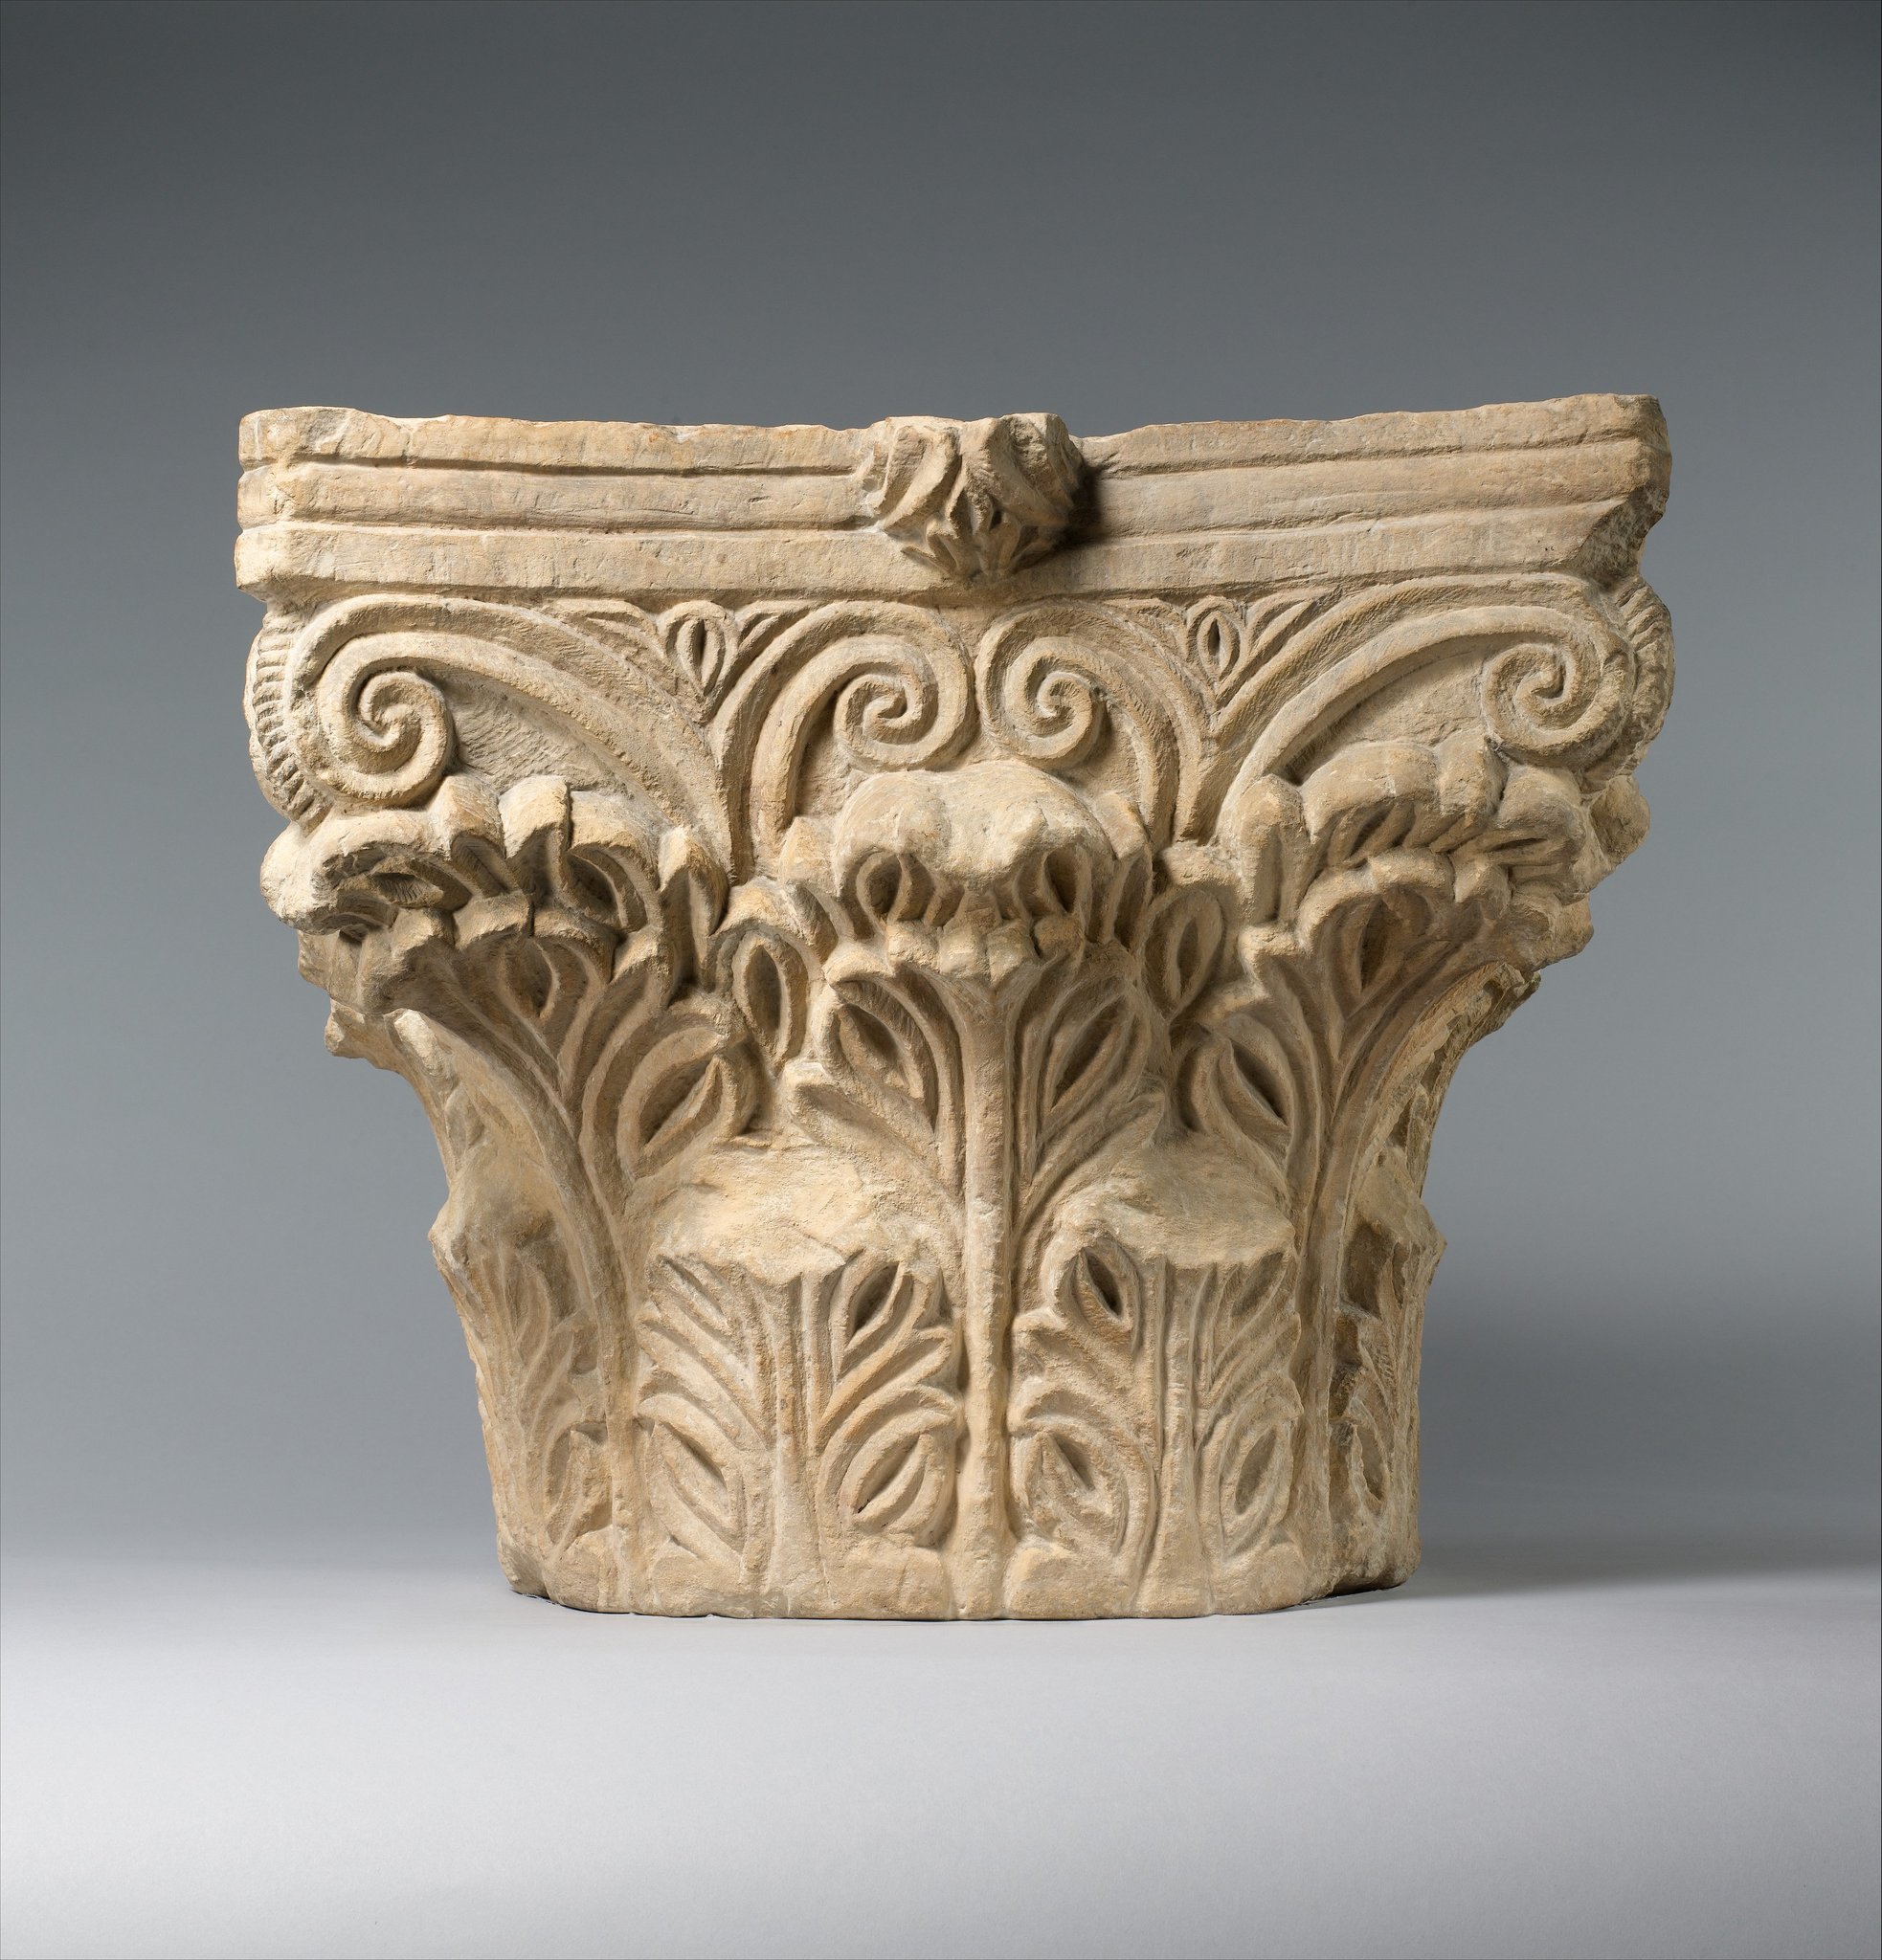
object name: capital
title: Capital with Acanthus Leaves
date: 501-600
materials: limestone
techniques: carving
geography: egypt